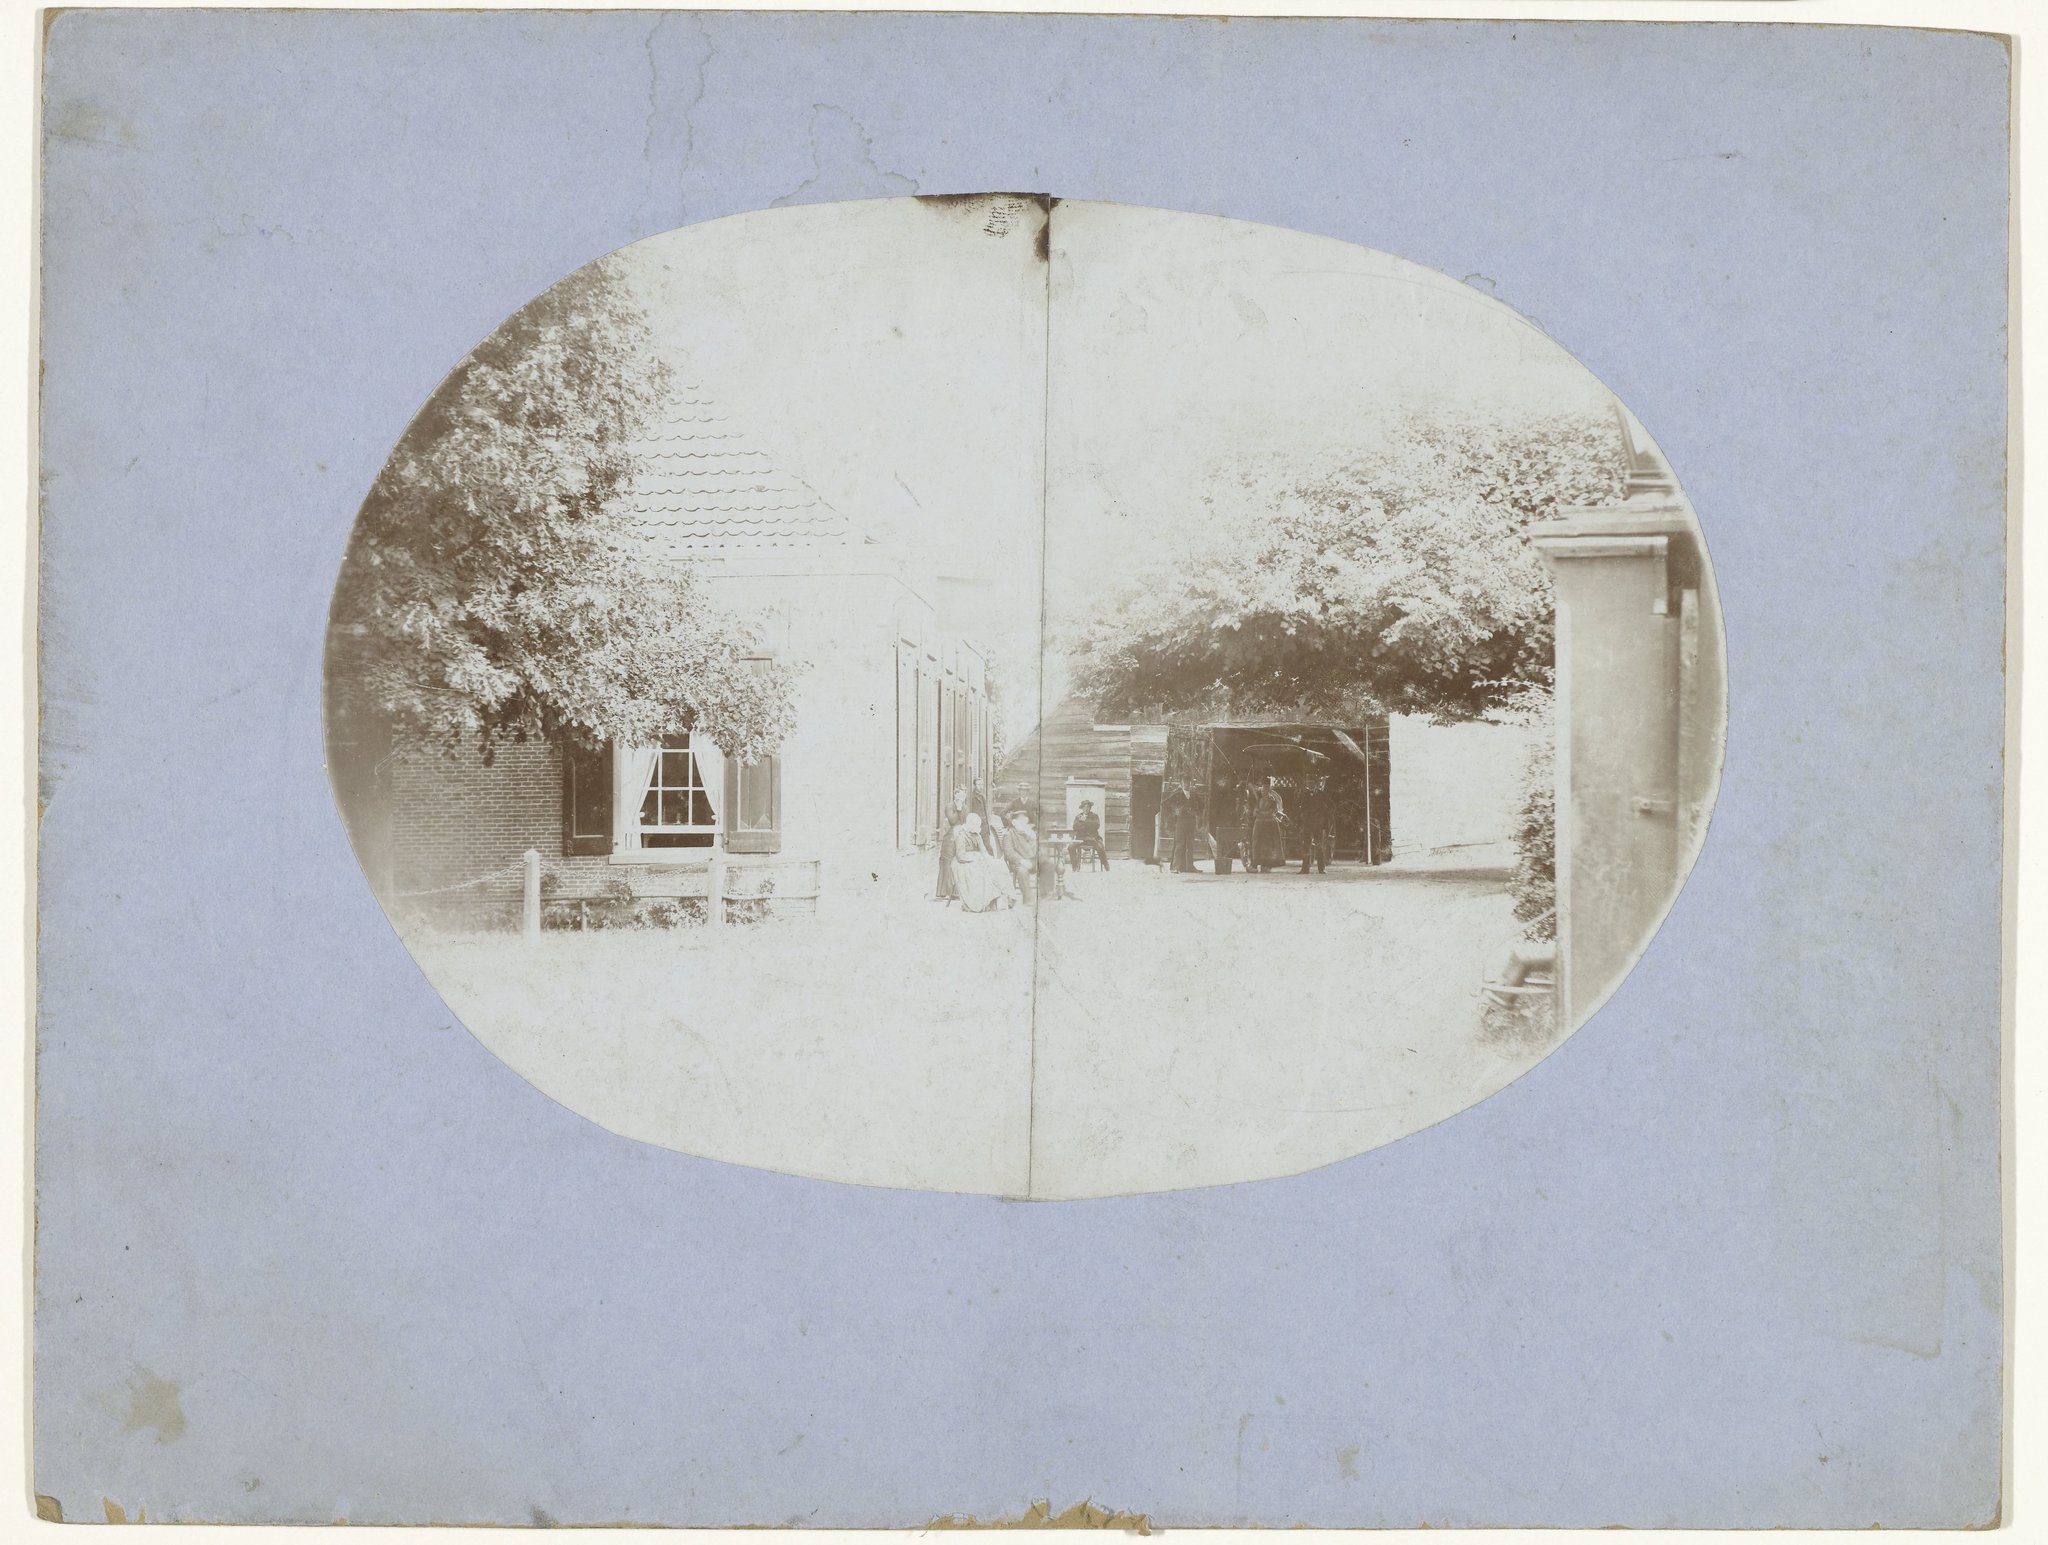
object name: photograph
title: Gezinsportret voor een boerderij met schuur.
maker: Anonymous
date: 1880-1920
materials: paper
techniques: collodion silver print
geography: netherlands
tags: family life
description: Het gezin zit aan de zijkant van de boerderij zodat ook de ingang van de schuur te zien is waar een rijtuig in gestald staat.